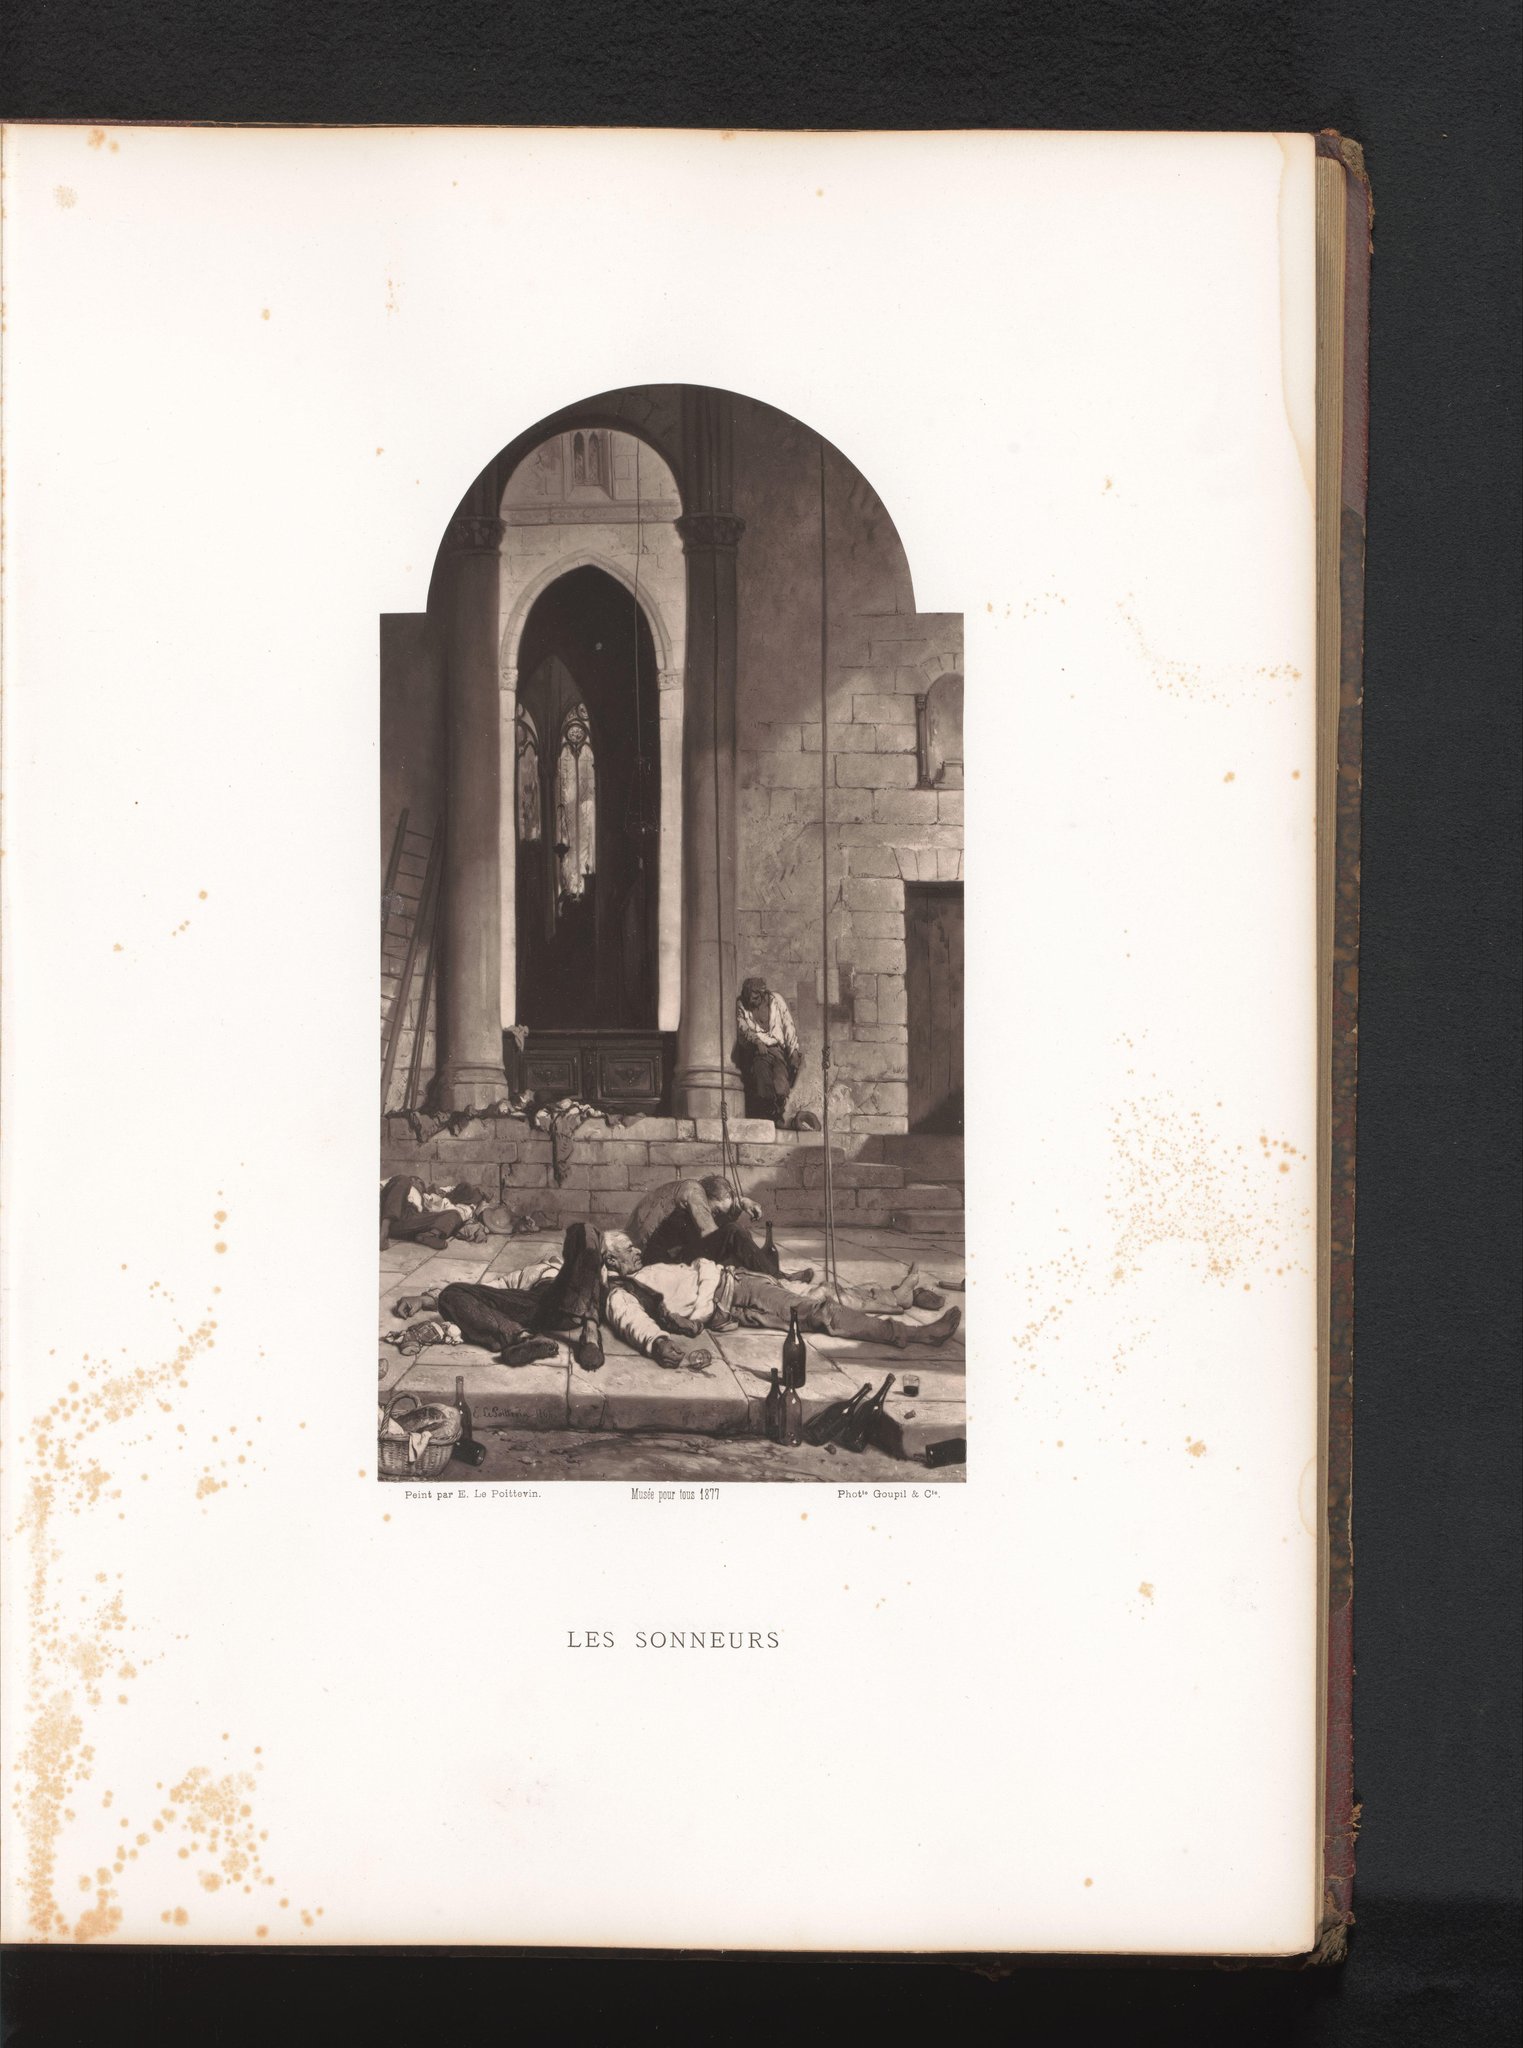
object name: photomechanical print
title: Reproductie van een schilderij van in slaap gevallen dronken portiers door Eugène Modeste Edmond Lepoittevin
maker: eugène modeste edmond lepoittevin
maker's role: painter, print maker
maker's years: 1806-1870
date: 1872-1879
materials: paper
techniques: woodburytype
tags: drunkenness, sleeping on the ground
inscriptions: inscription: ‘Musée pour tous 1877’